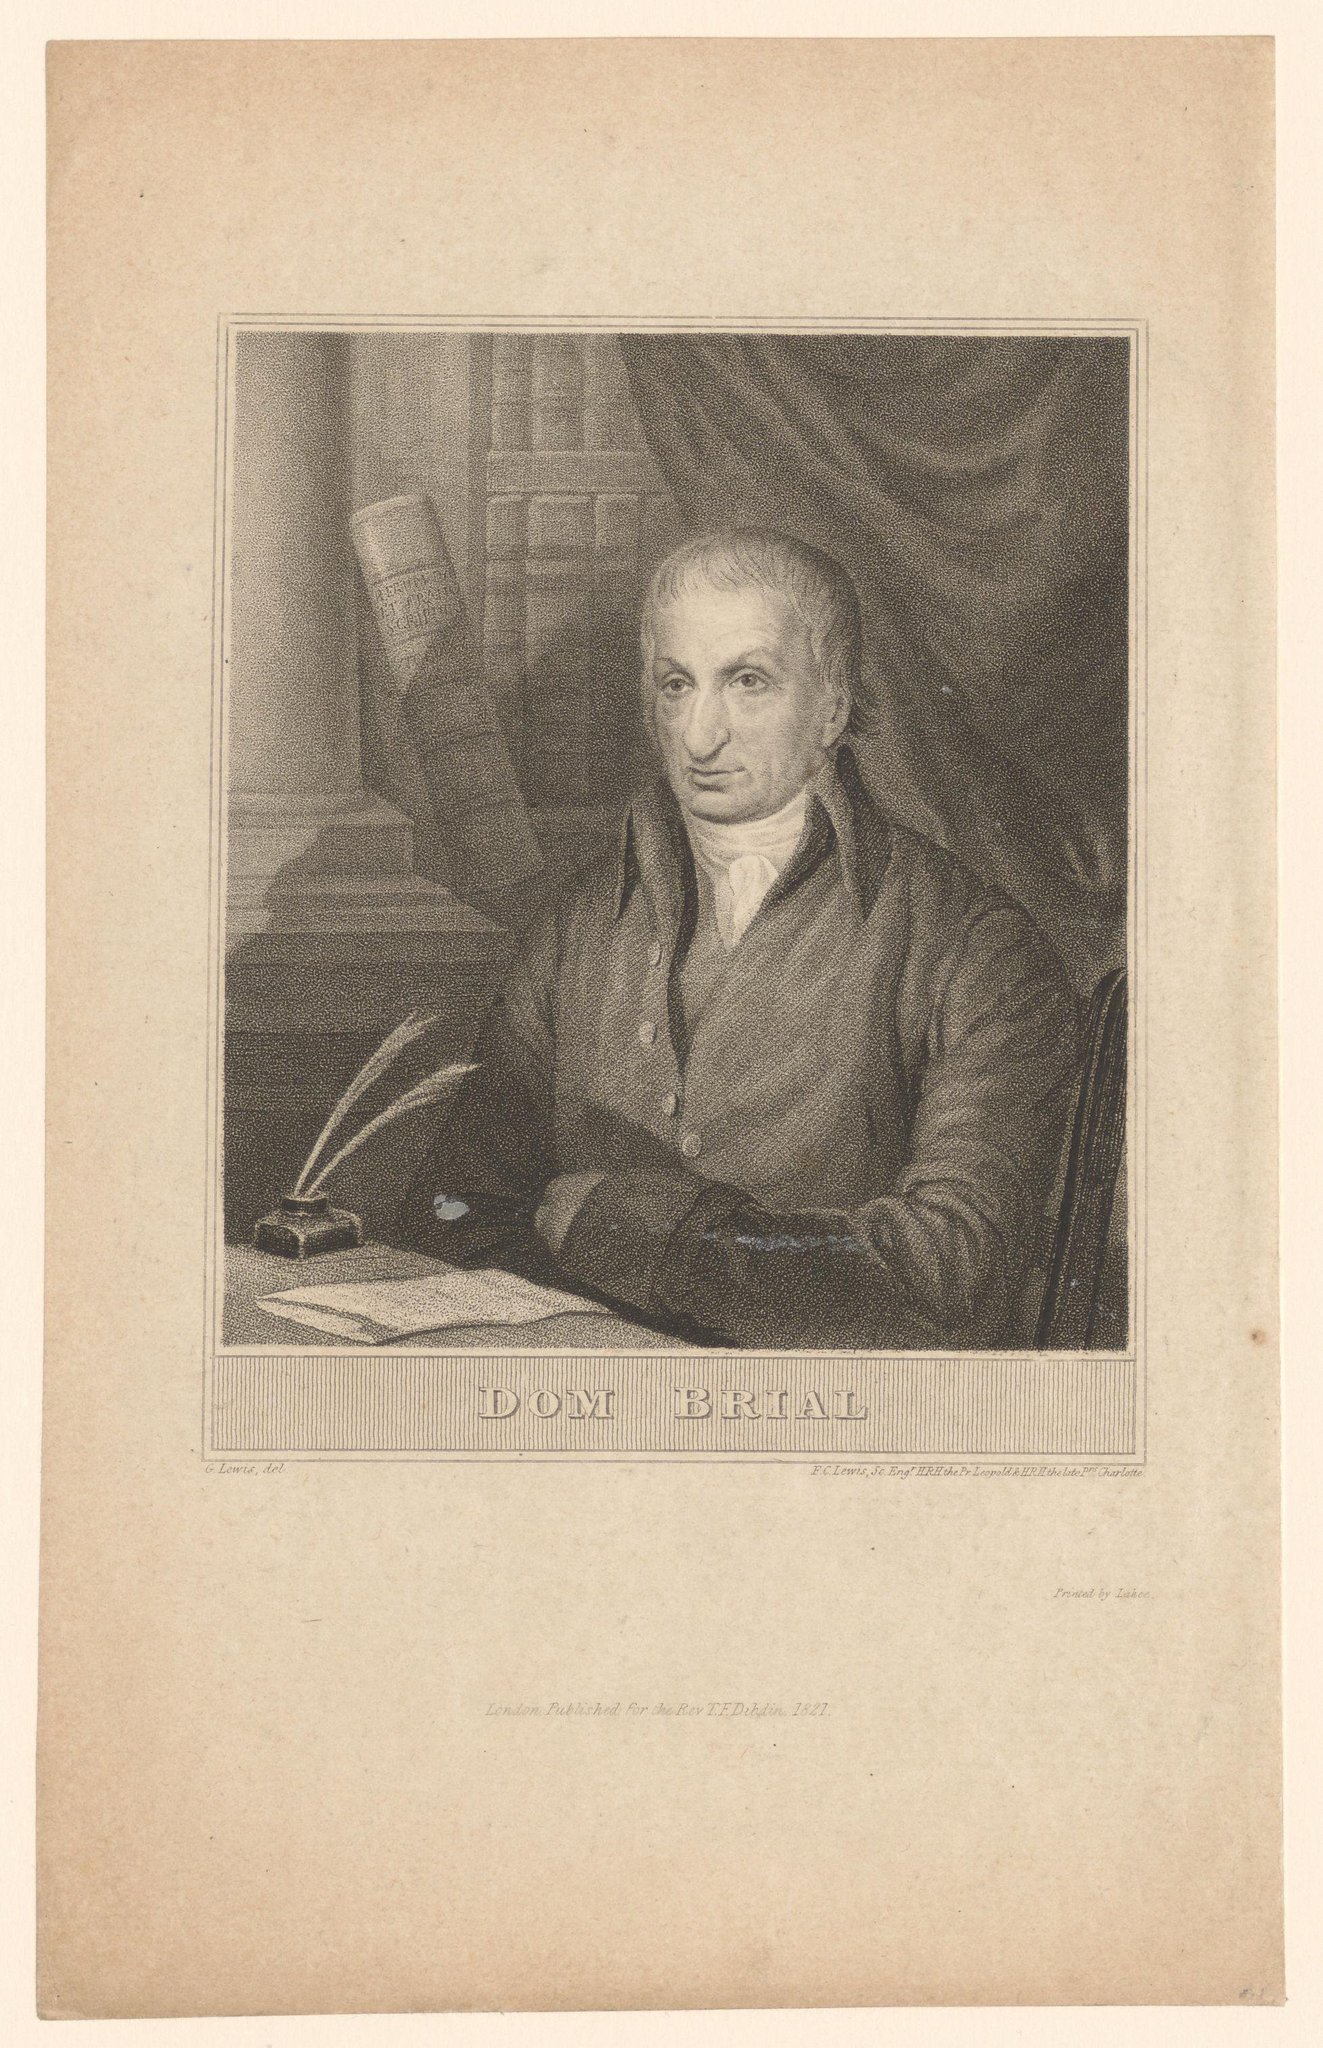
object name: print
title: Portret van Michel Jean Joseph Brial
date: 1821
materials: paper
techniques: stippling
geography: london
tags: history and archaeology (+ portrait of scholar, scientist), historical persons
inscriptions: collector's mark: Lugt 2228